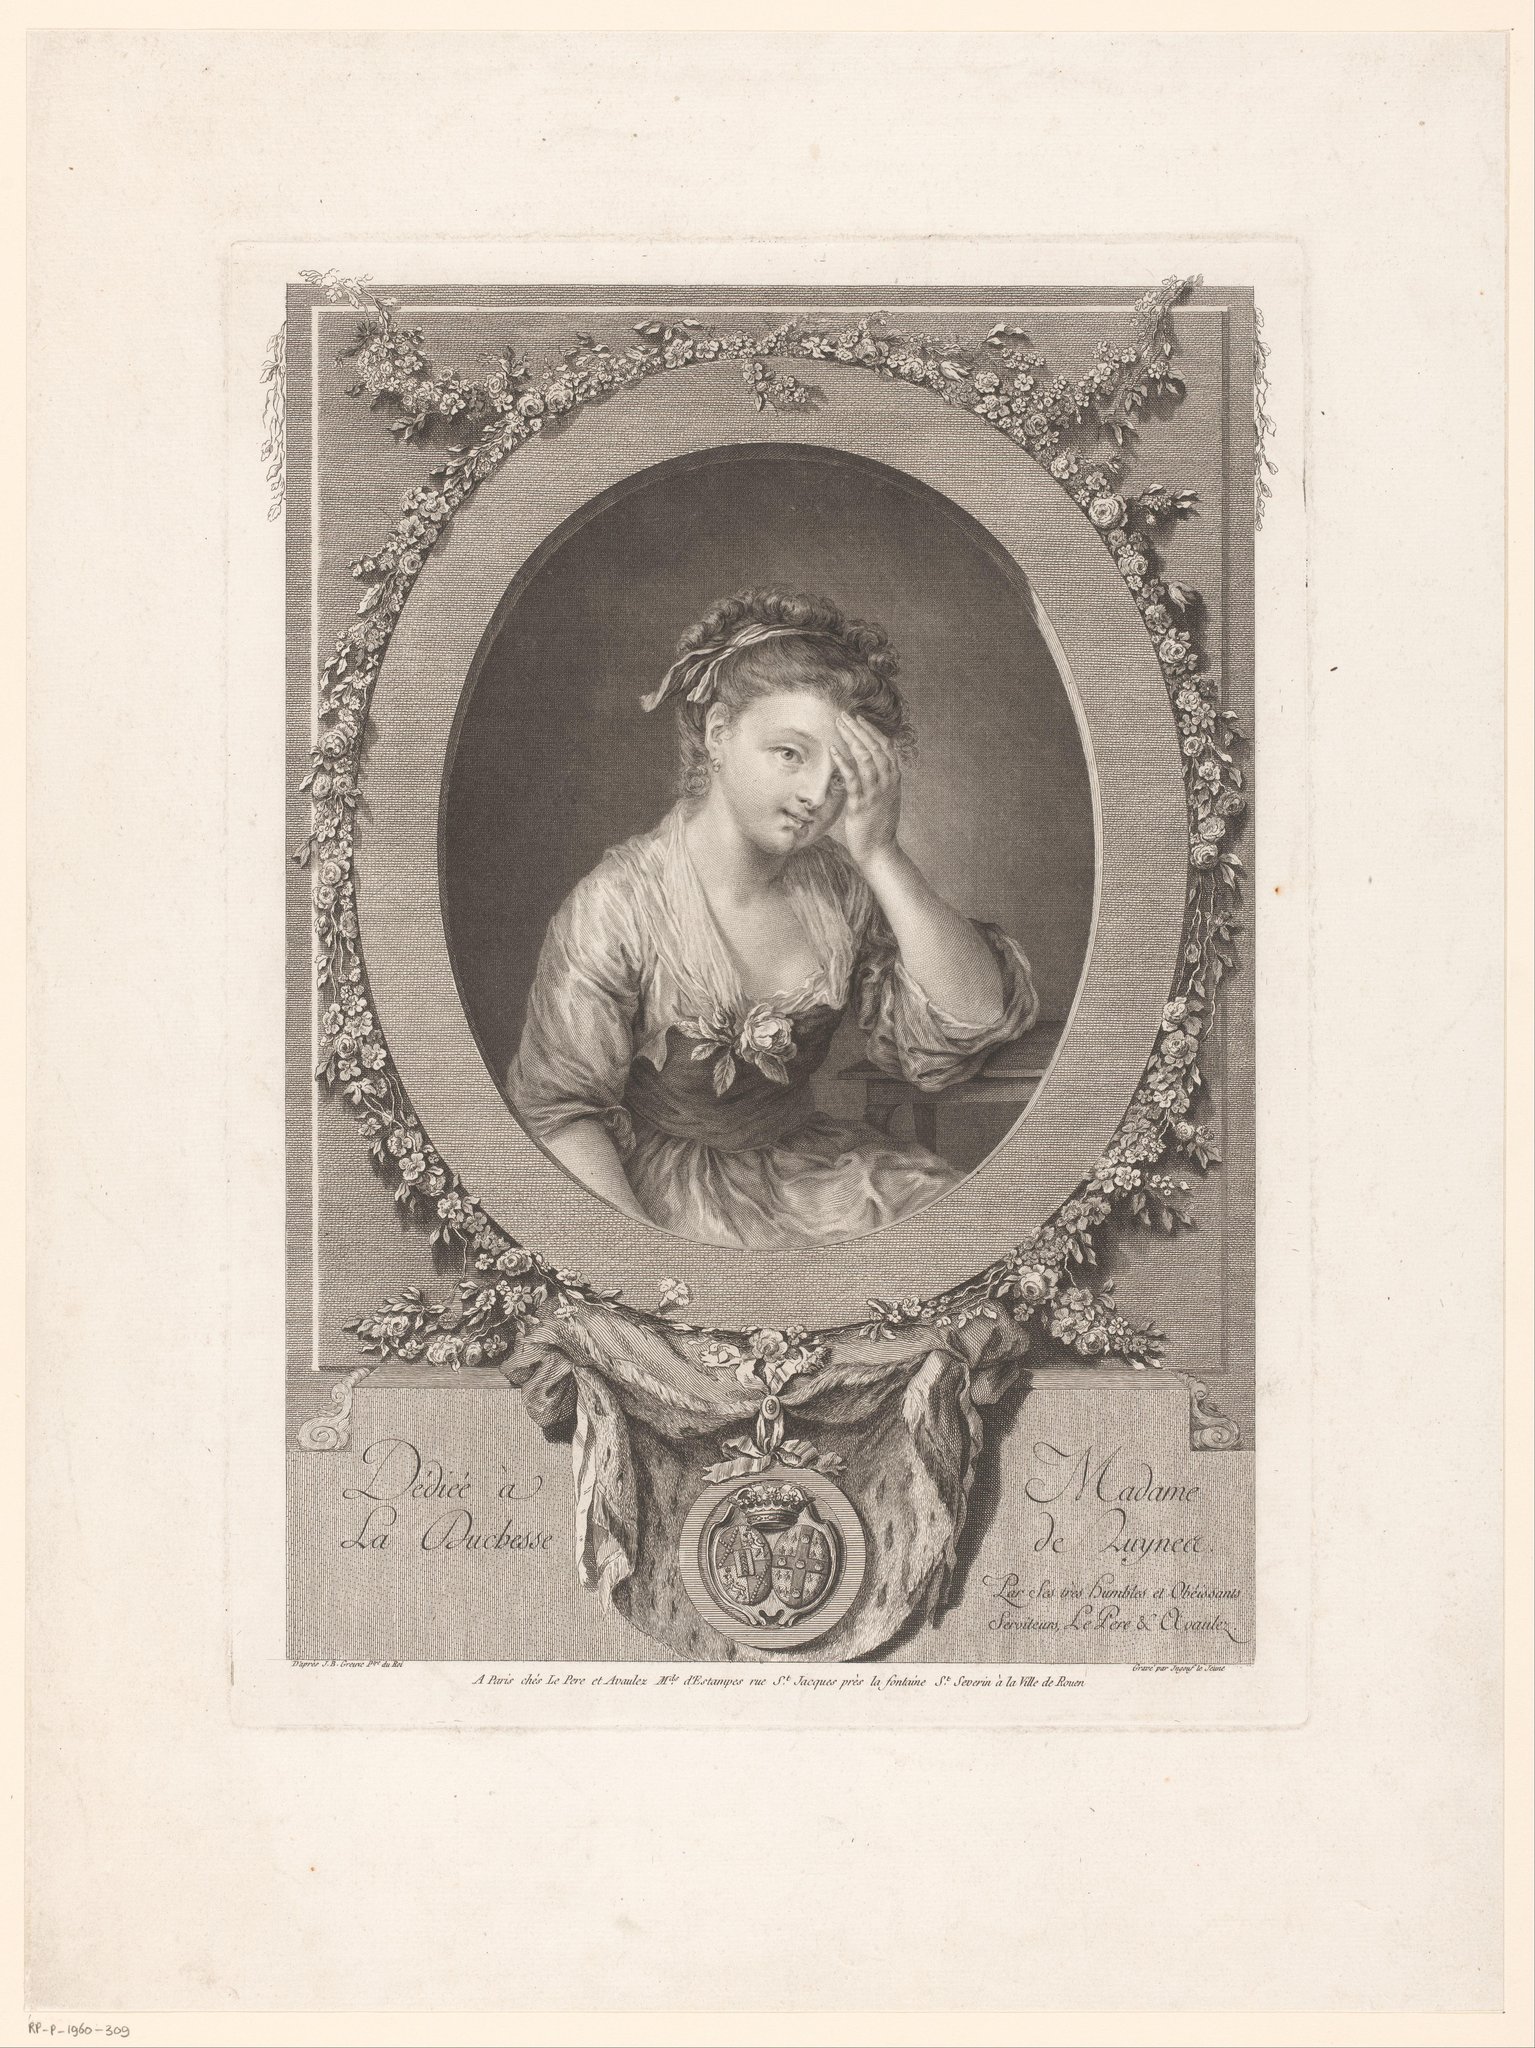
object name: print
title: Jonge vrouw met hand aan haar hoofd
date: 1773-1774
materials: paper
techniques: engraving, etching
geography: paris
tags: adolescent, young woman, maiden, ornament ~ cartouche, armorial bearing, heraldry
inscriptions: collector's mark: Lugt 2228